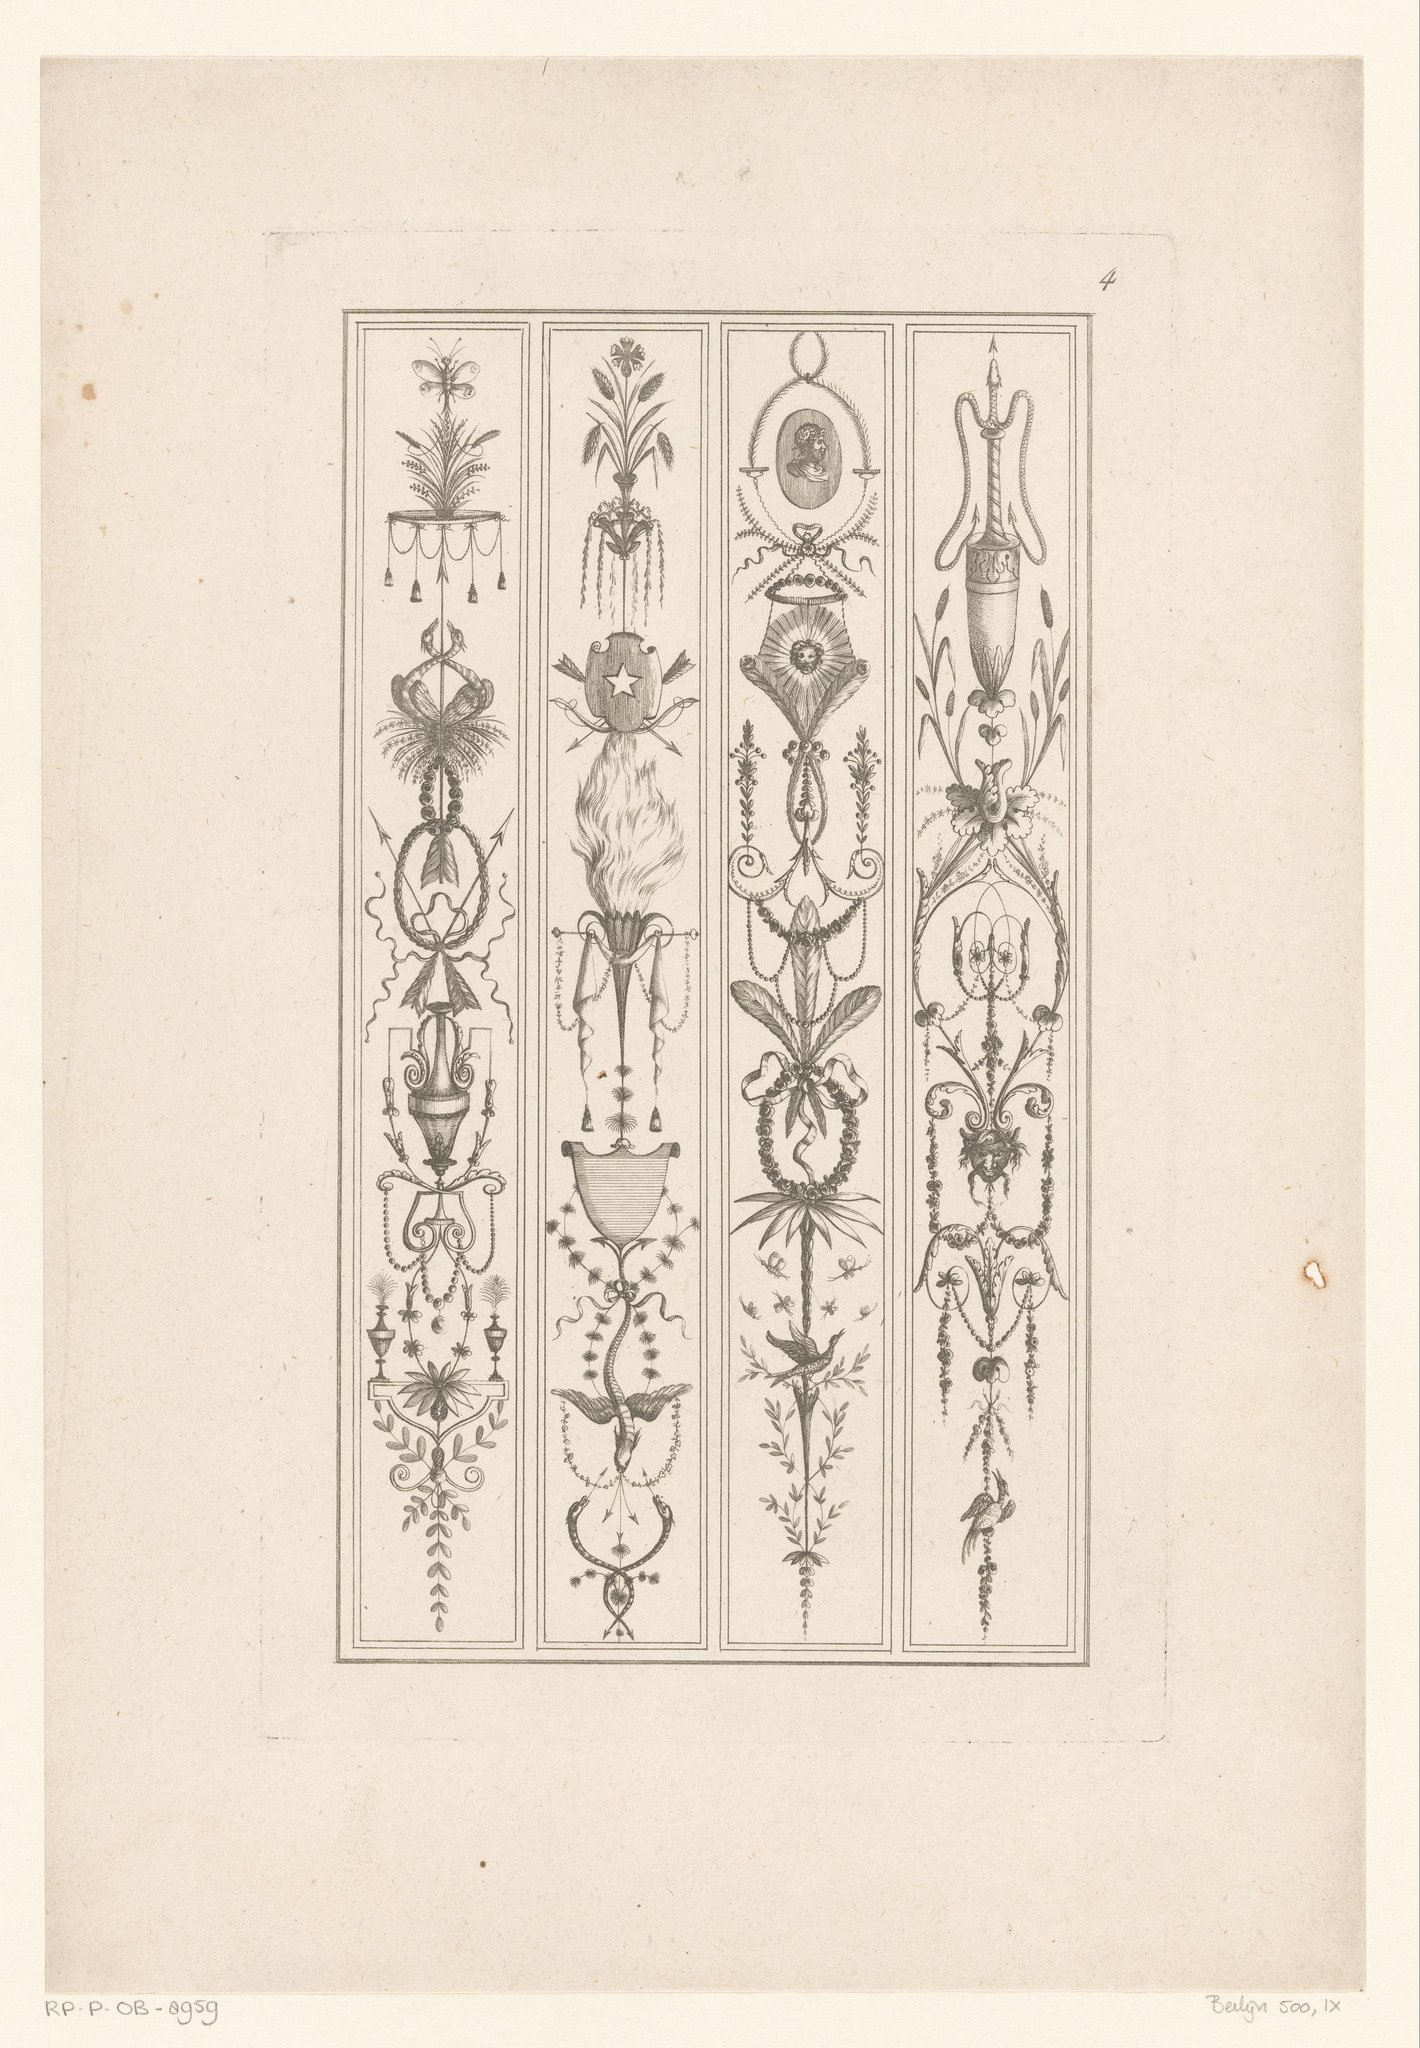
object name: print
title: IXe Cahier d'Arabesques et Bordures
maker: jean baptiste fay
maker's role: print maker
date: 1784-1796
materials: paper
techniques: engraving, etching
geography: paris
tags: torch, ornament ~ arabesque, birds, vase ~ ornament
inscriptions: collector's mark: Lugt 2228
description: Vier verticale panelen met arabesken en vogels, pijlen, vazen, een fakkel, slangen, een medaillon, veren, lisdodden en een masker.